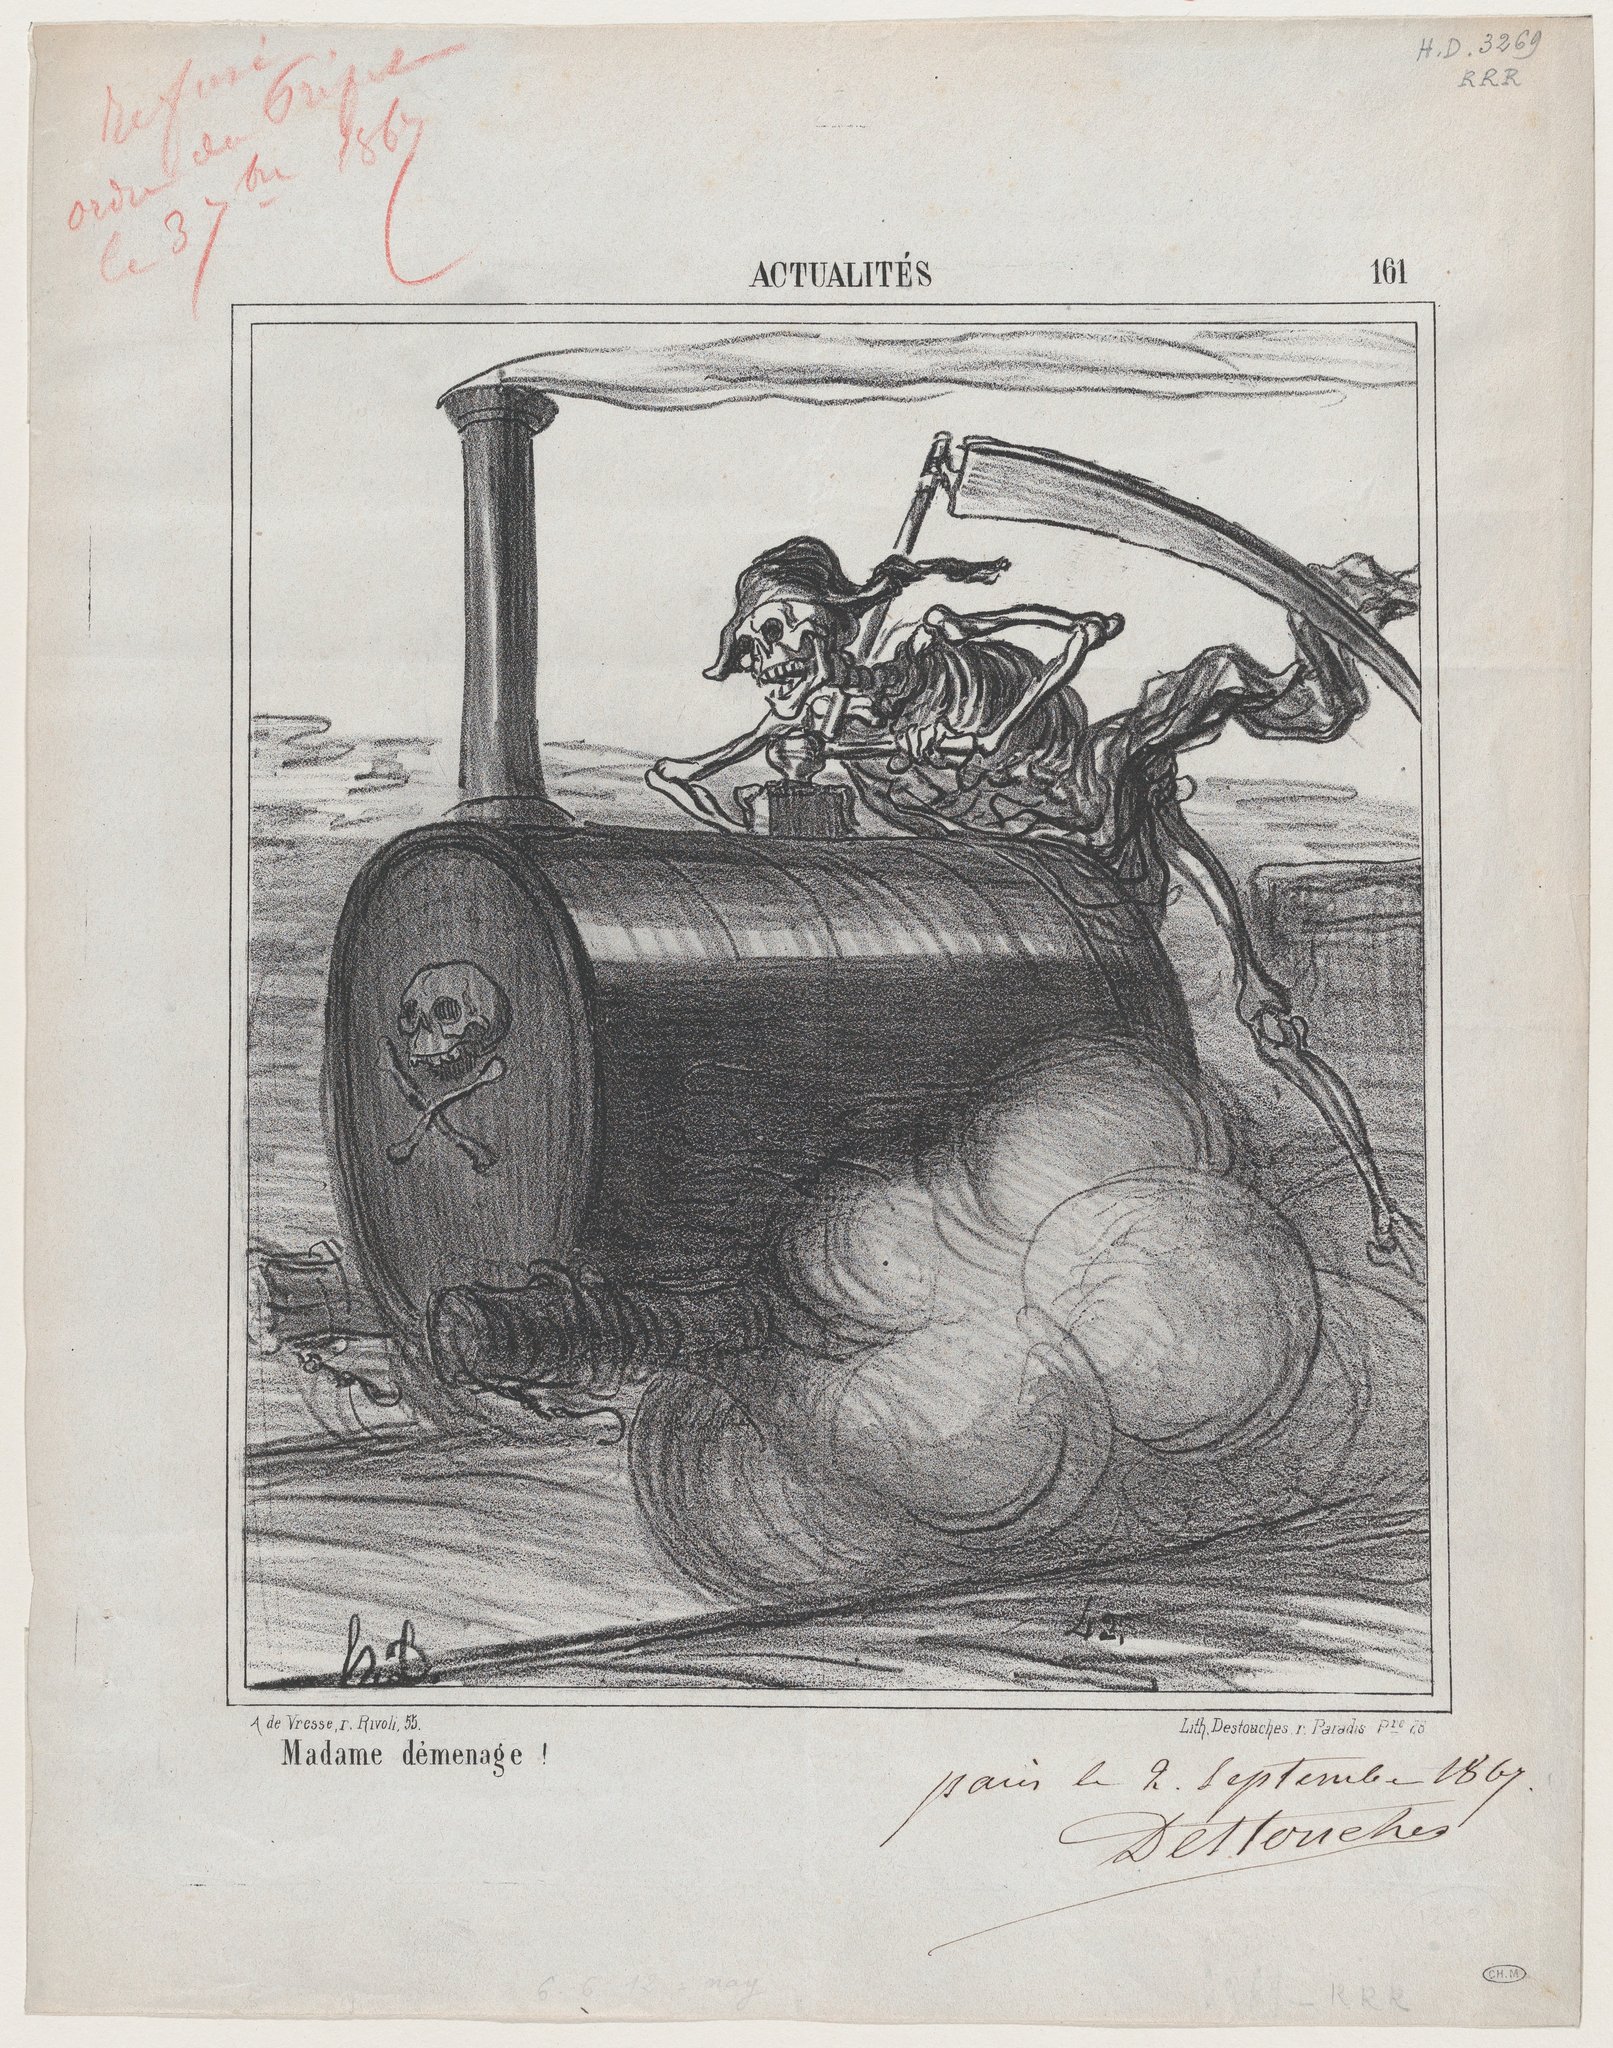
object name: print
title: Madame is moving, from 'News of the day'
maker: honoré daumier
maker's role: artist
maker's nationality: french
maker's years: 1808-1879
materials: ink, paper, pencil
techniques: lithograph, pen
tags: satire,skeletons,trains